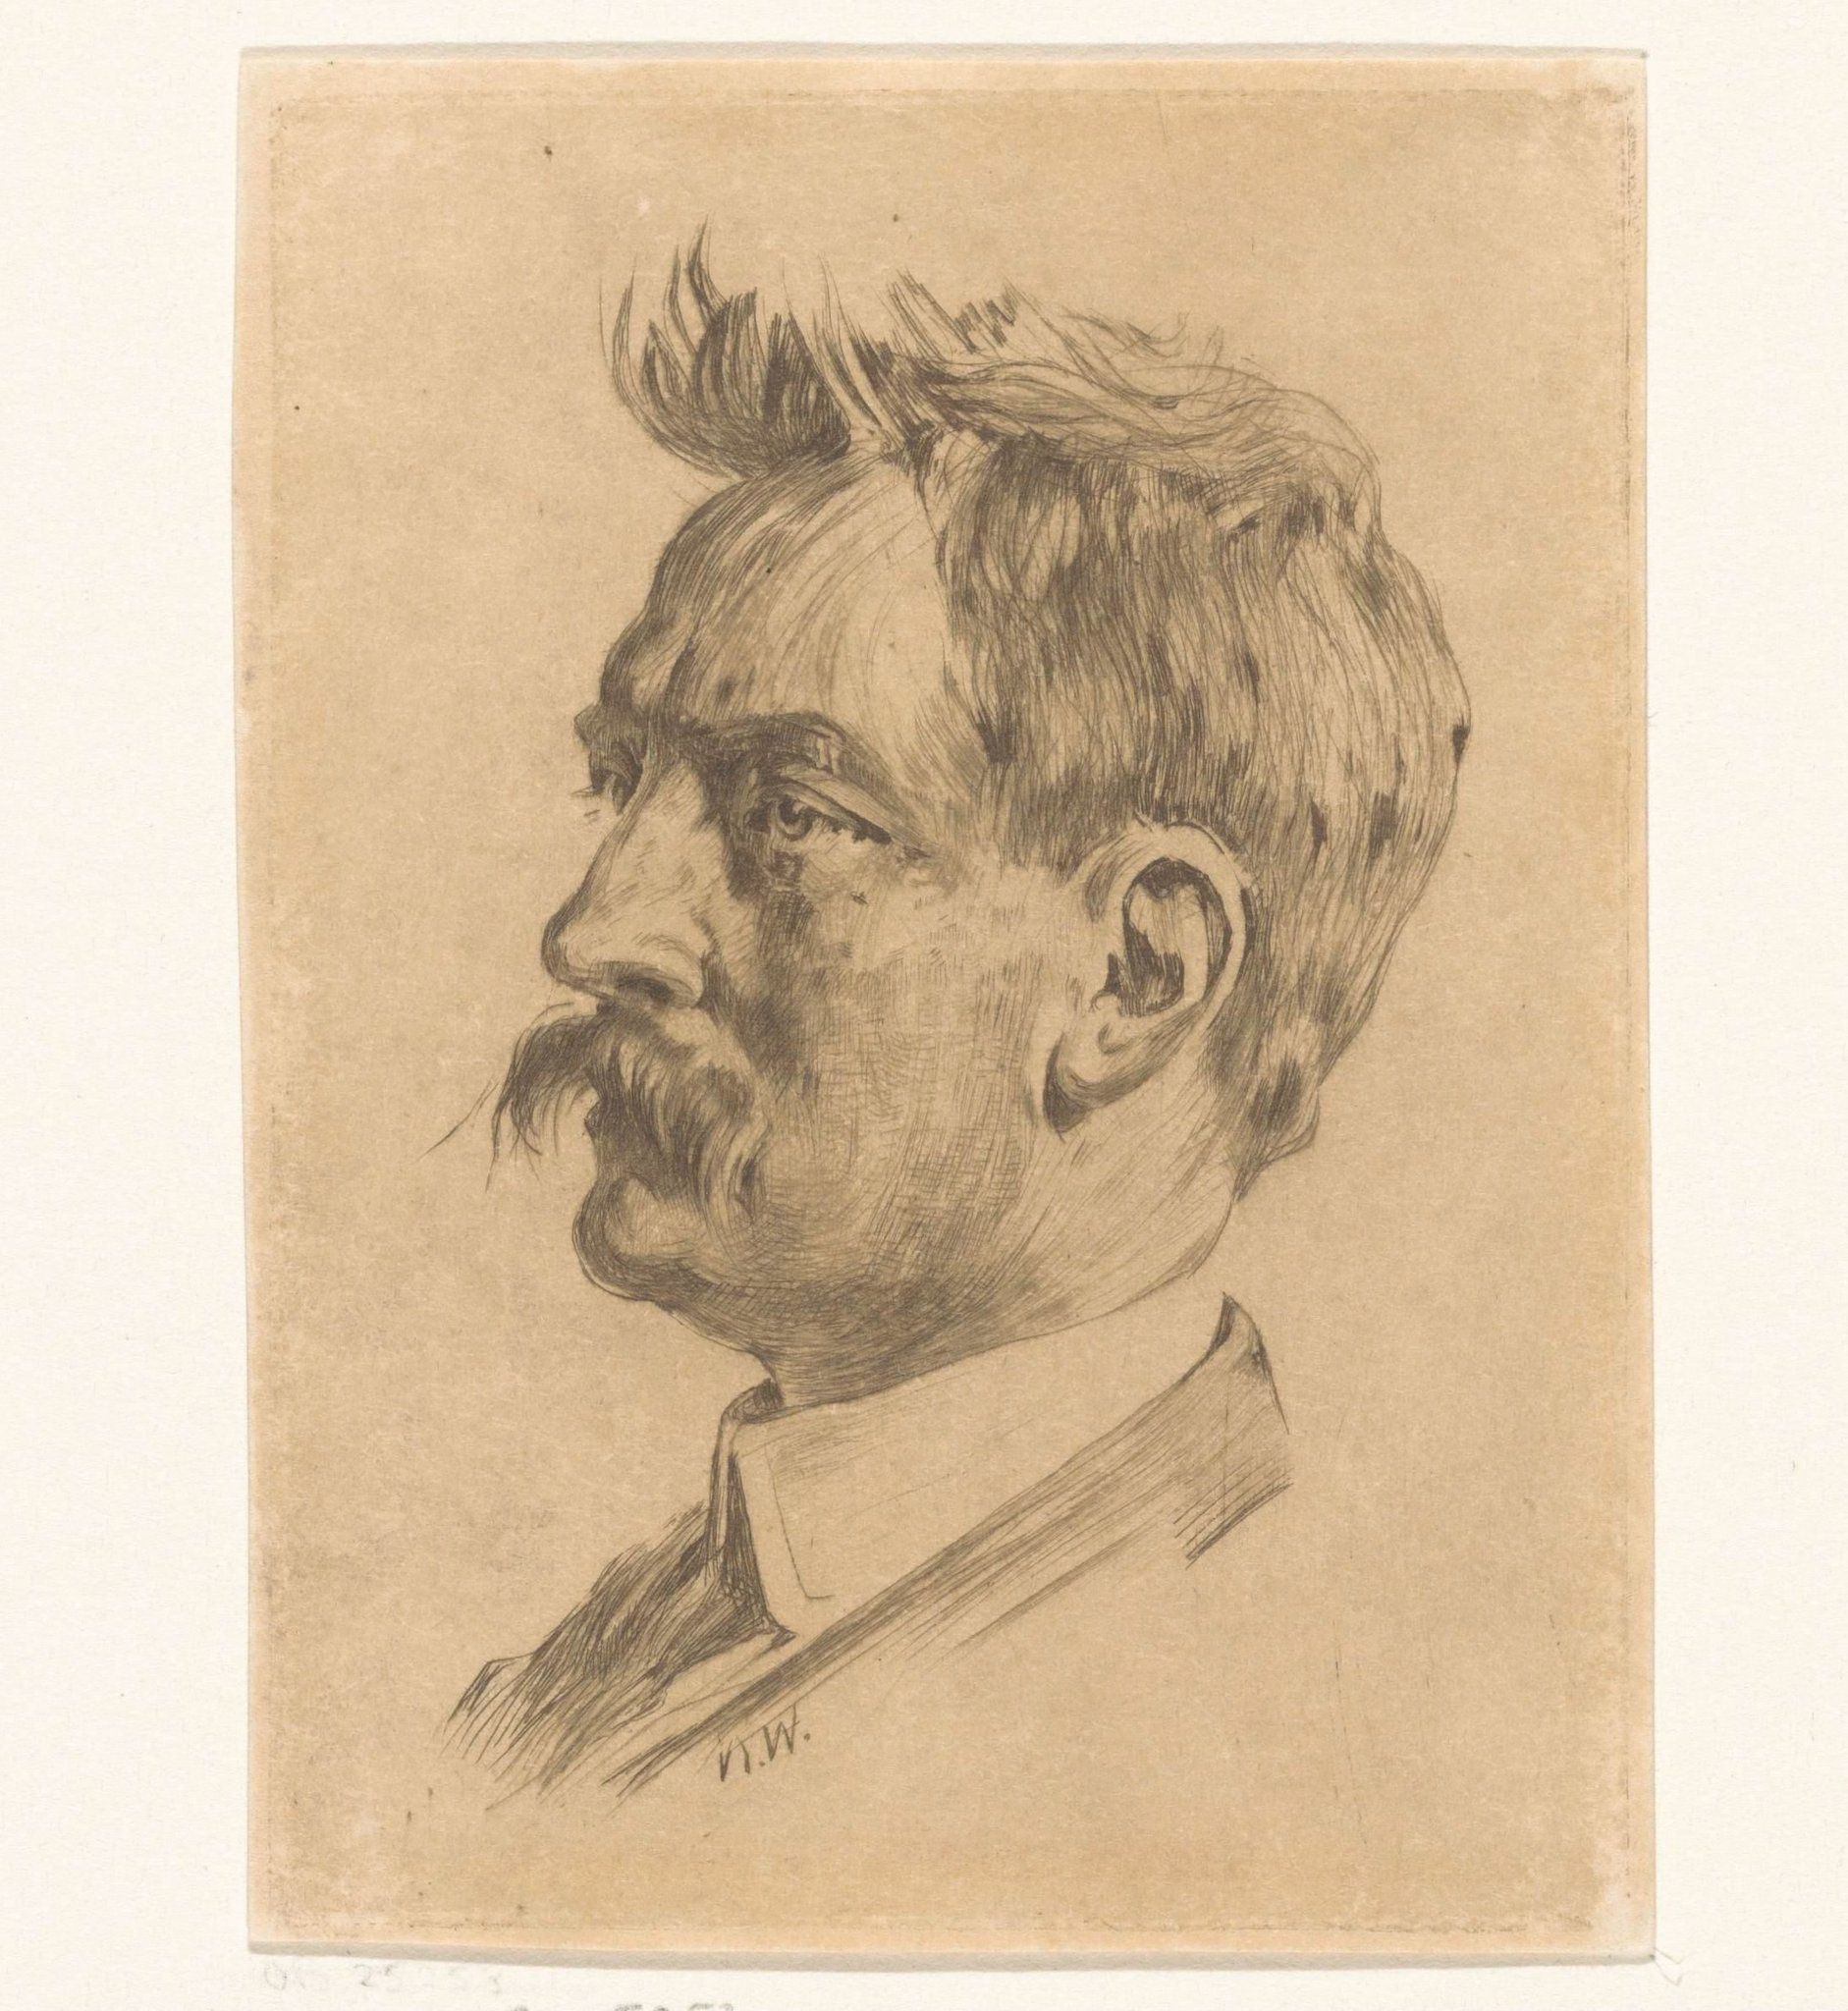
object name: print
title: Portret van Jan Hofker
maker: willem witsen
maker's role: draughtsman, painter, print maker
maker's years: 1860-1923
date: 1906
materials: paper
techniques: drypoint, etching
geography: amsterdam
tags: portrait of a writer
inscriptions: inscription: ‘W. Witsen Portret van Jan Hofker (Nieuwe Gids redactie) ETS’, collector's mark: Lugt 2760, collector's mark: Lugt 2228